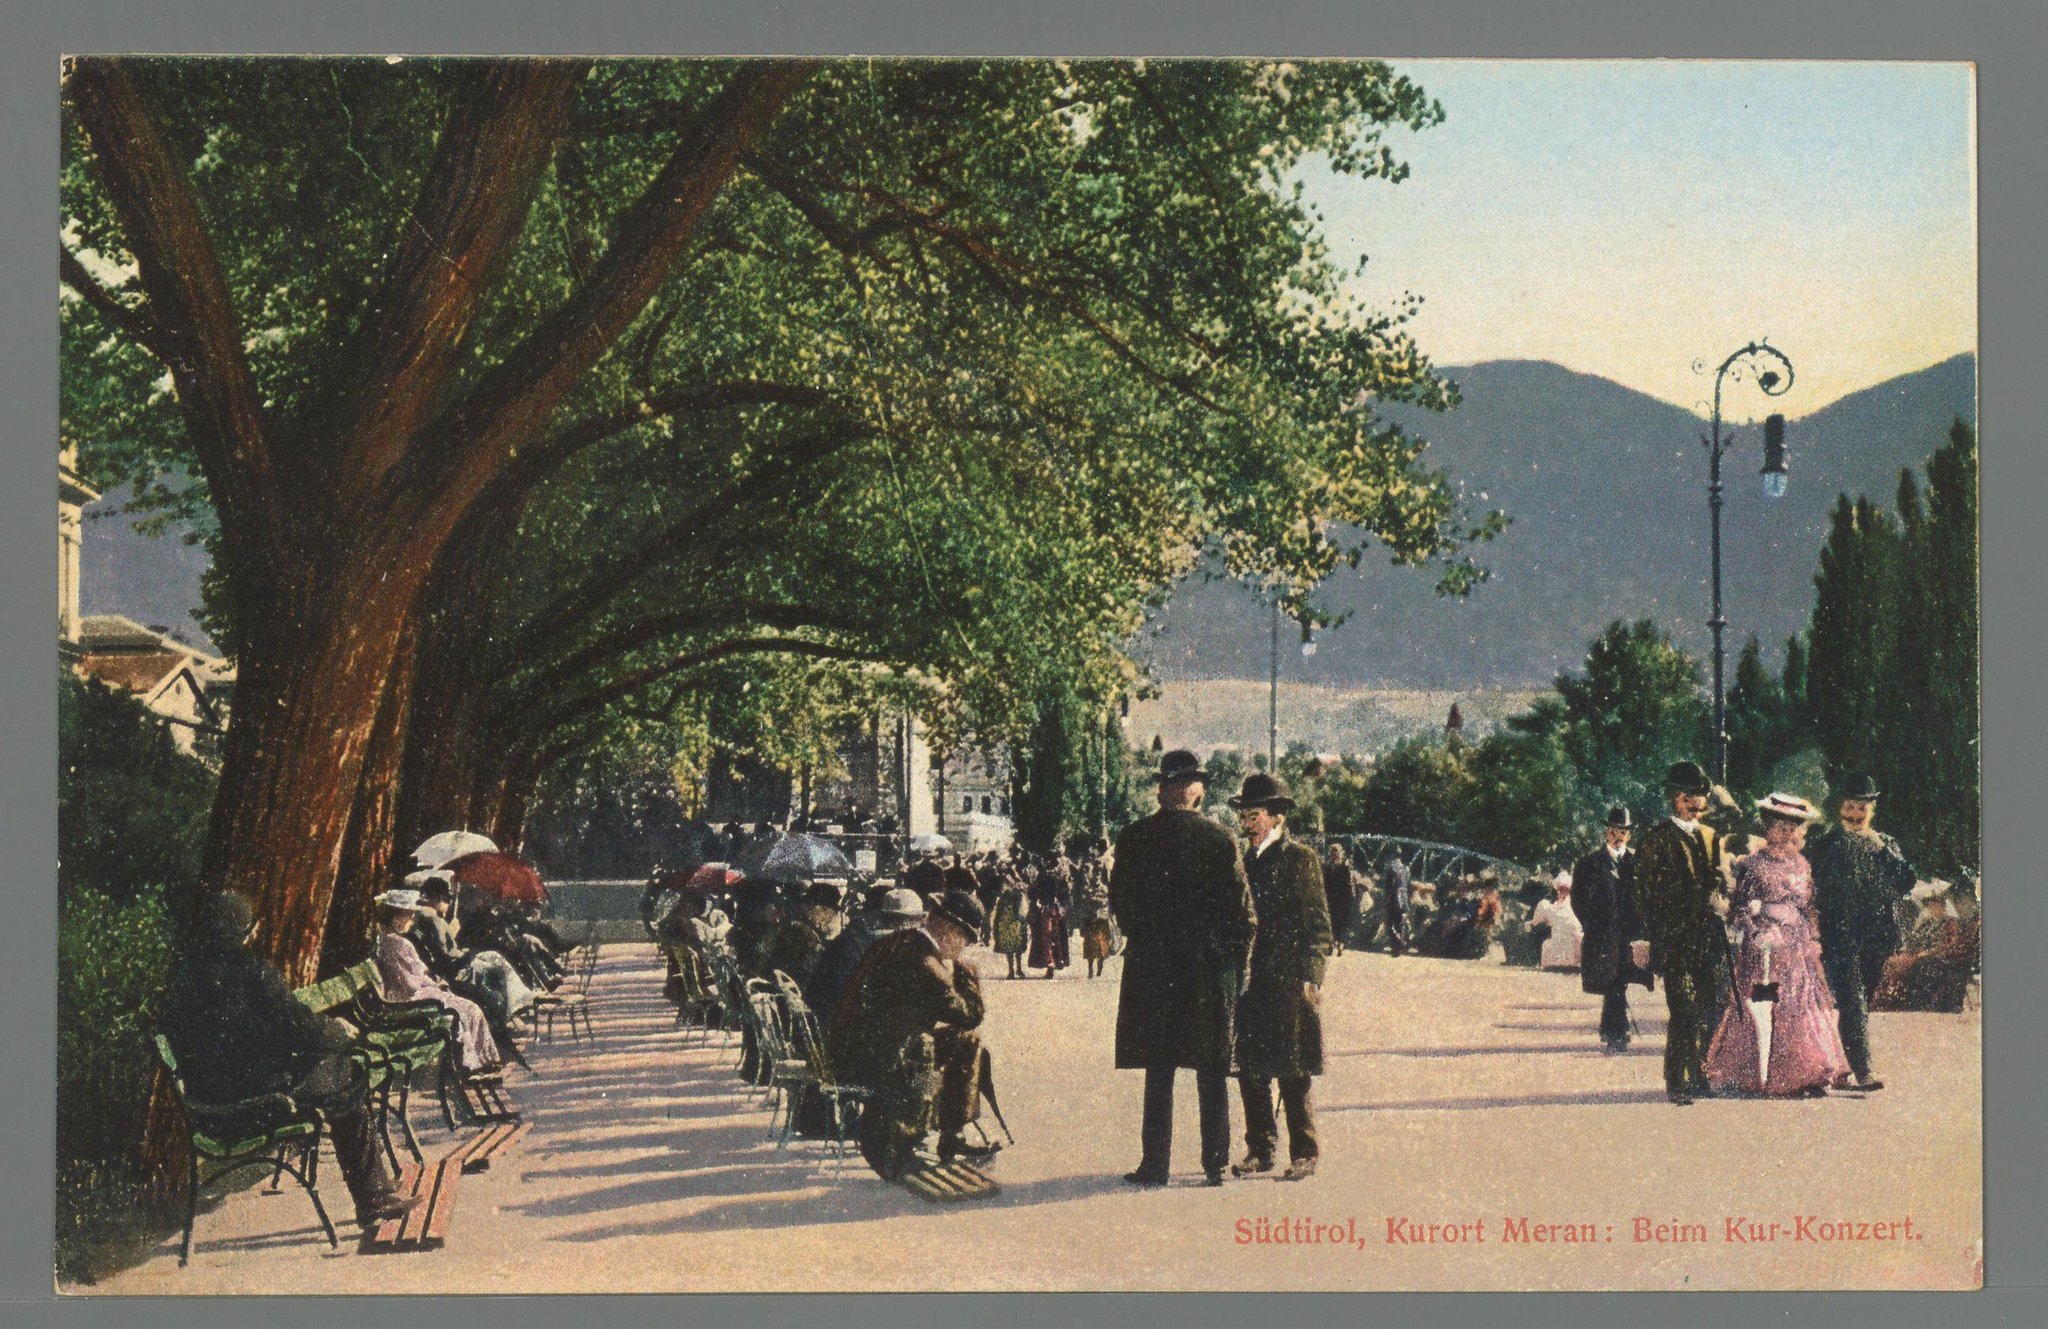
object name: photomechanical print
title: Südtirol, Kurort Meran: Beim Kur-Konzert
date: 1910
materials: cardboard, photographic process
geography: merano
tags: trees, avenue, boulevard, promenade, esplanade (+ city(-scape) with figures, staffage)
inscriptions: date